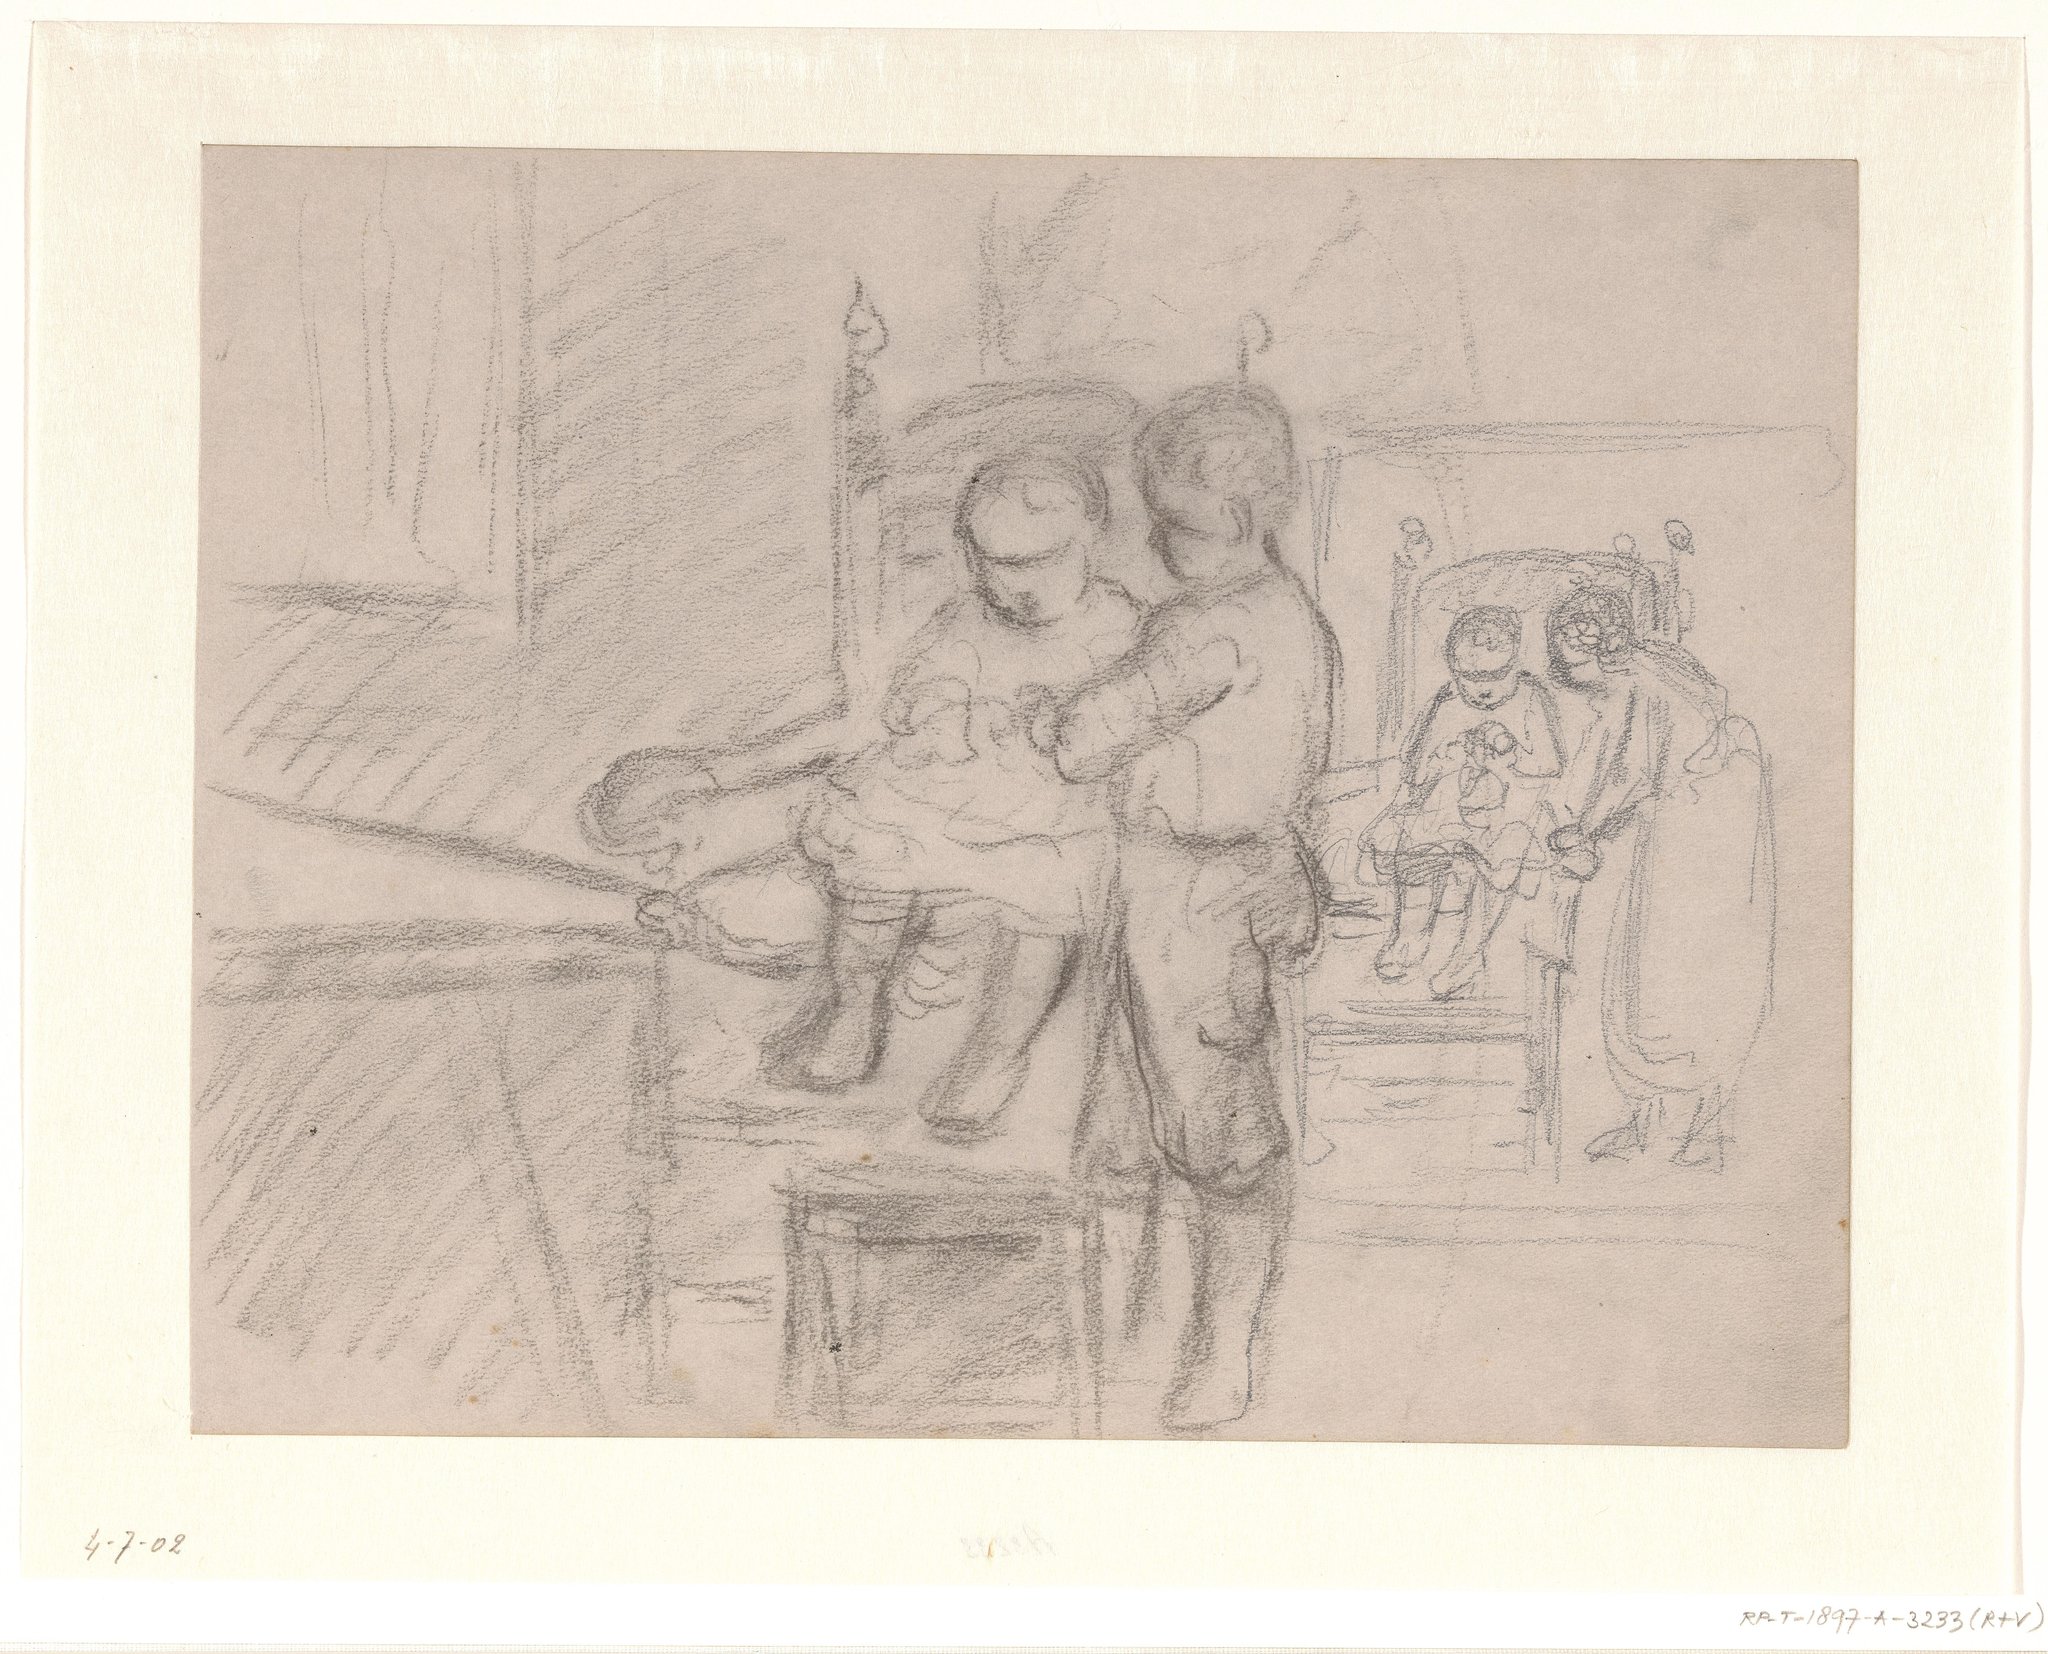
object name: drawing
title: Jongen en meisje bij leunstoelen met kleine kinderen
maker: hendrik valkenburg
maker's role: draughtsman, painter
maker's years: 1826-1896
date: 1836-1896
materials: chalk, paper, pencil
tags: adult woman, interior of the house, mother and child(ren), woman and child(ren) (family group)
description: Jongen bij een leunstoel met een klein kind, rechts een meisje bij een tweede leunstoel met een kind.